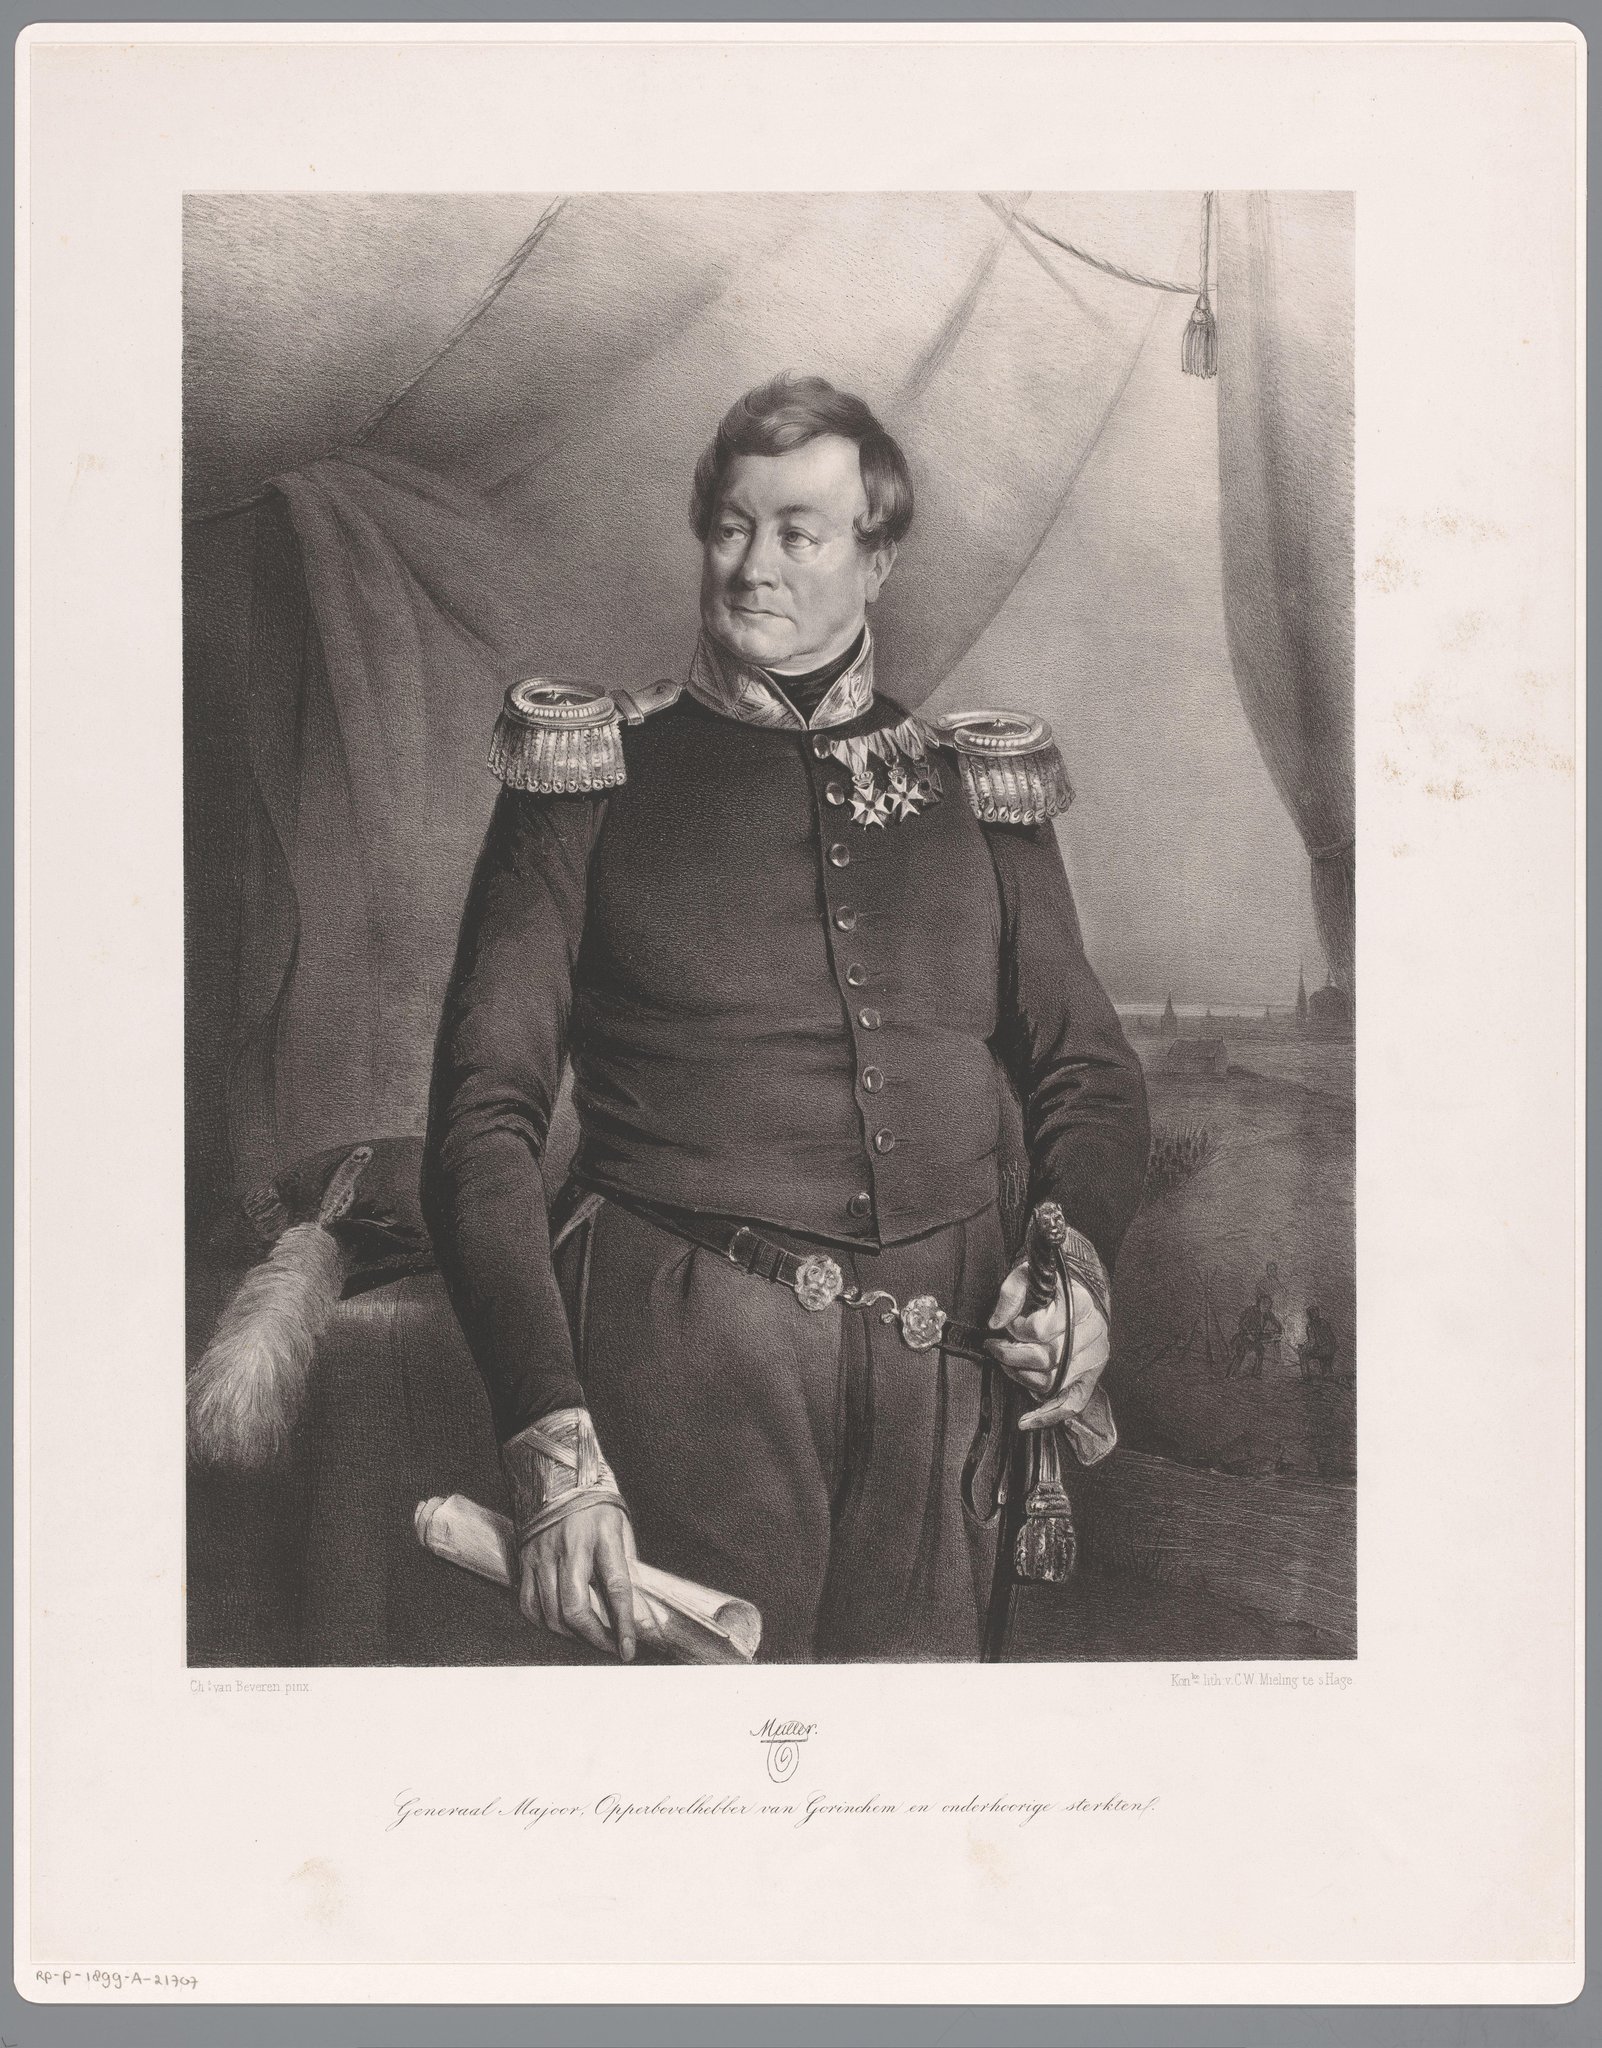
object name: print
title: Portret van Generaal Majoor Muller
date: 1847-1865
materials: paper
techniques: lithograph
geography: the hague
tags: knighthood order, camp-fire; watch-fire, prospect of city, town panorama, silhouette of city, historical persons (+ three-quarter length portrait)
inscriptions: collector's mark: Lugt 2228, inscription: ‘Mijnheer Kinschot’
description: De geportretteerde draagt een militair uniform met ridderorden en staat voor de opening van een tent of opgetrokken gordijn. In zijn rechterhand heeft hij een opgerold stuk papier. Rechts van hem een landschap met in de verte een dorp. In de voorgrond een rivier en enkele figuren die vuur maken. Onder het portret de signatuur van de geportretteerde.